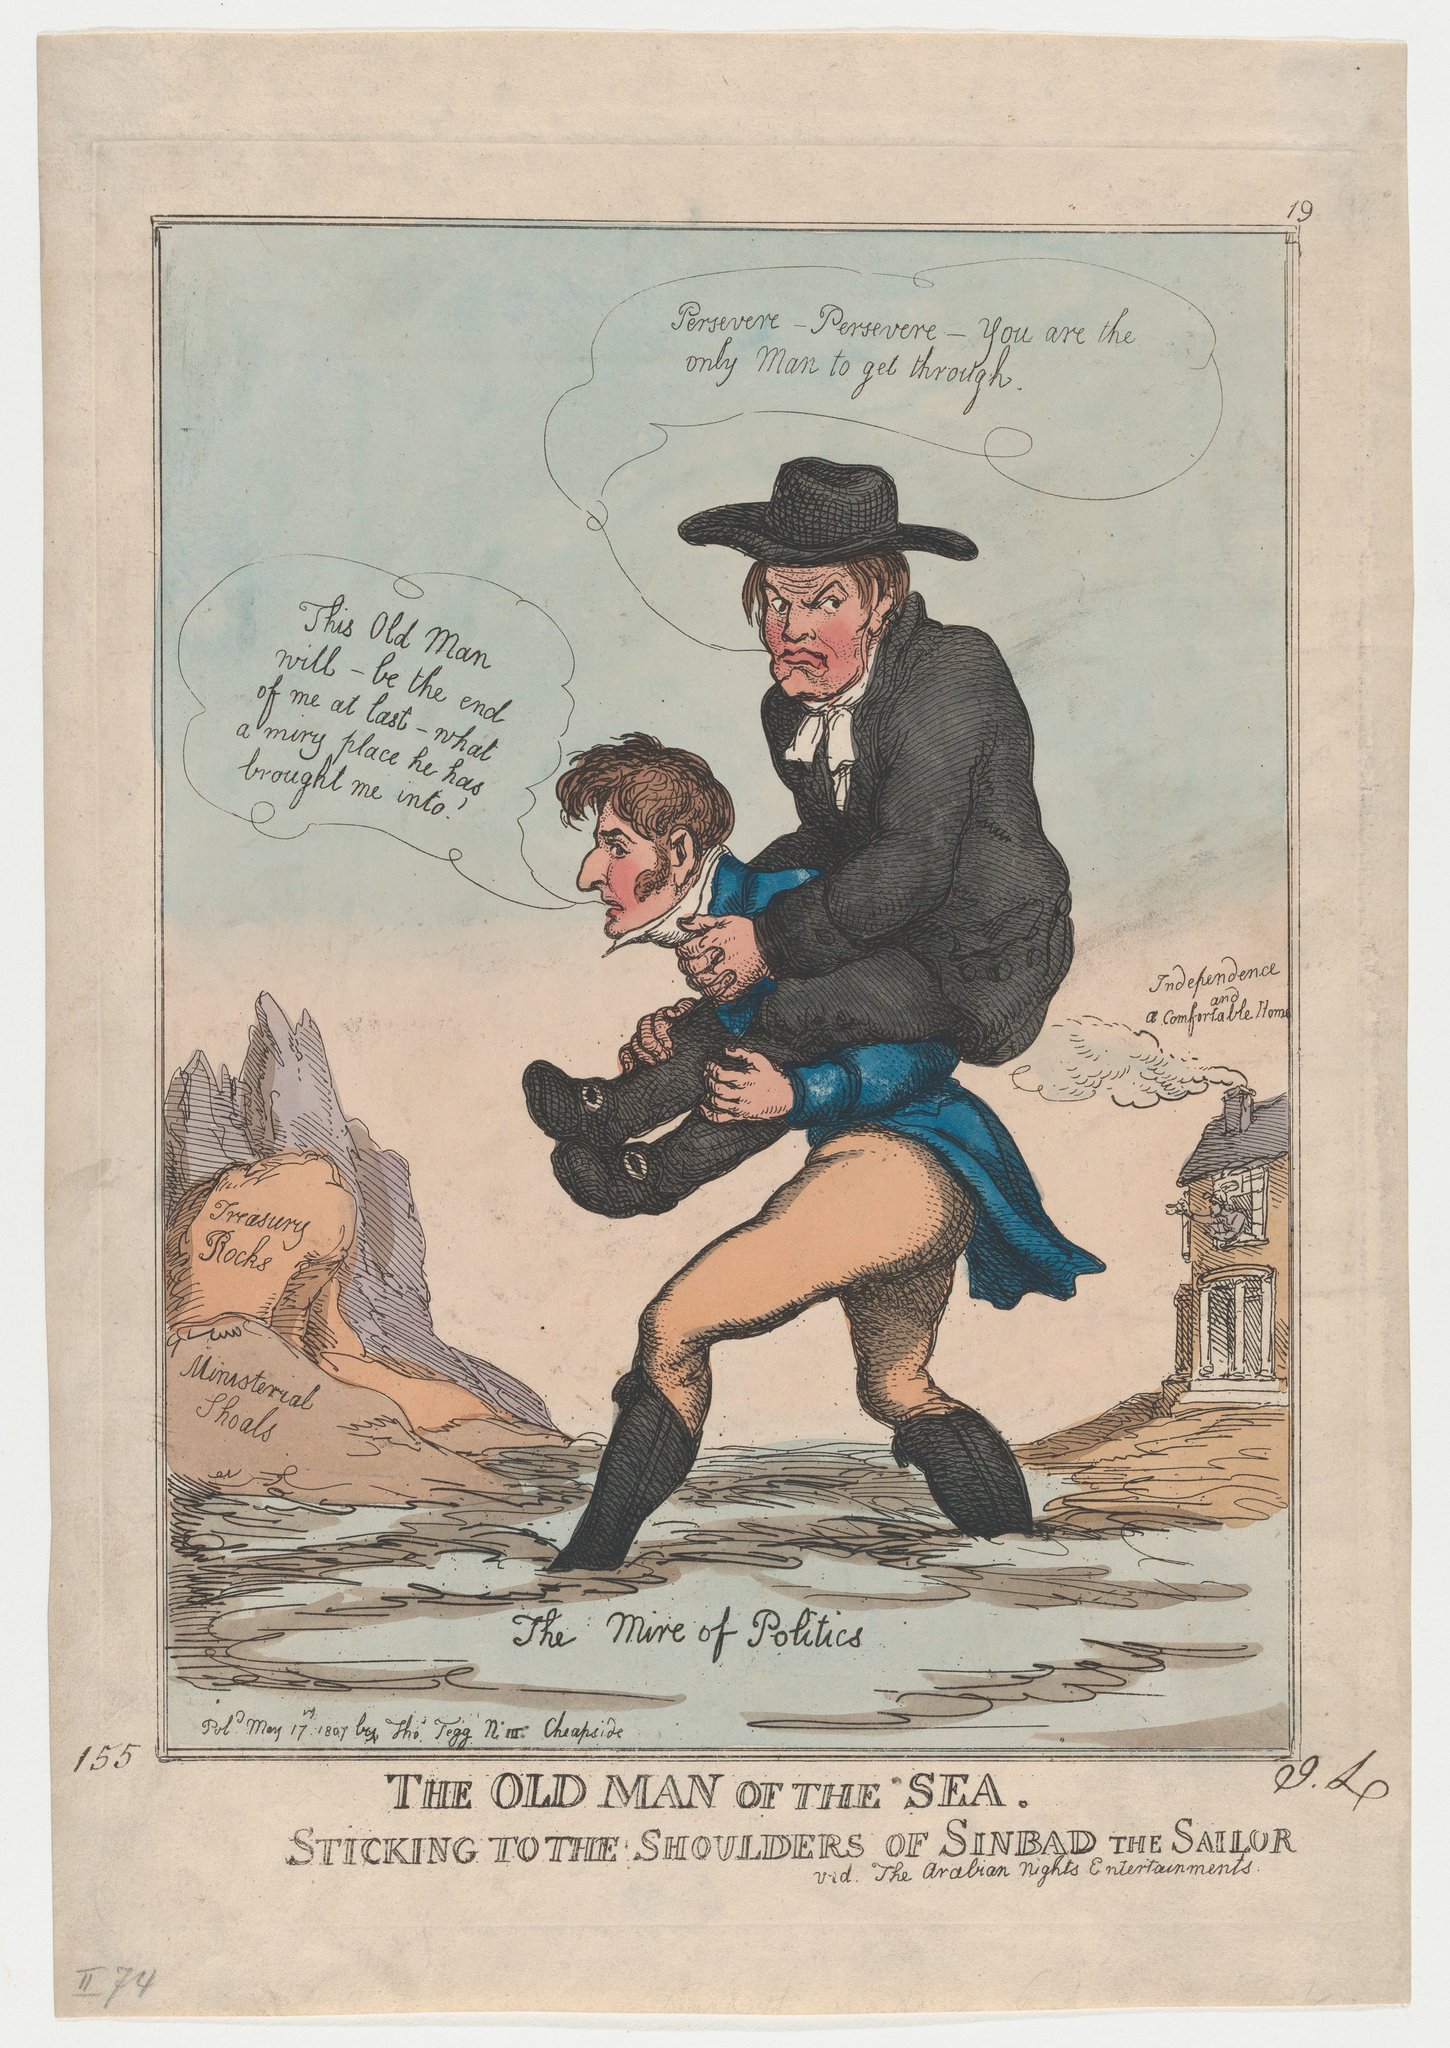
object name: print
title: The Old Man of the Sea, Sticking to the Shoulders of Sinbad the Sailor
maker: thomas rowlandson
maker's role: artist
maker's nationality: british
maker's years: 1757-1827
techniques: etching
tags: satire,men,sailors,politics